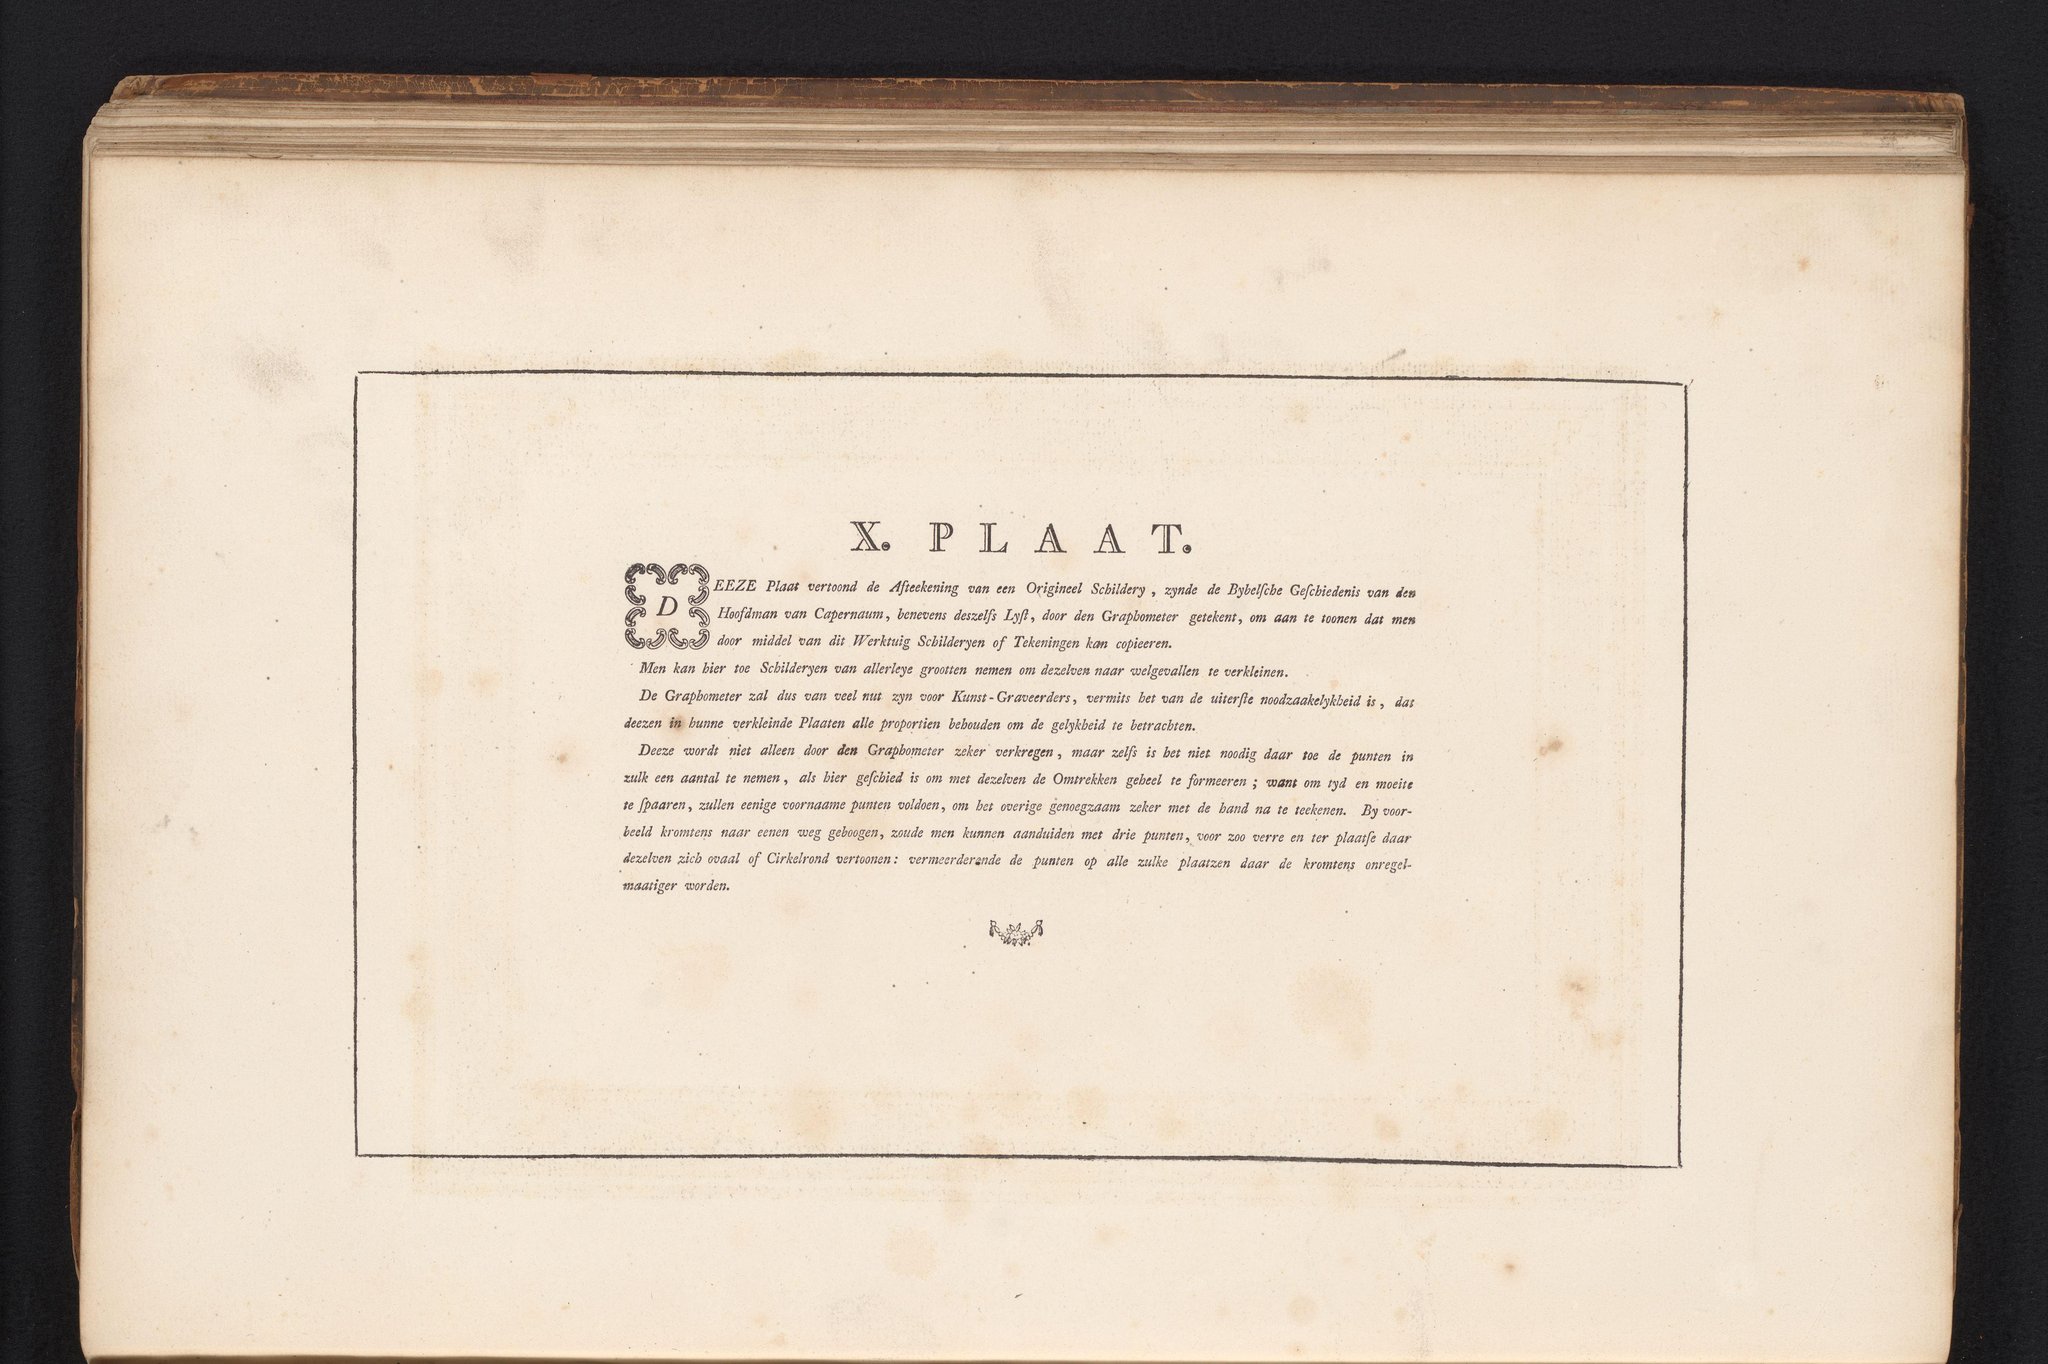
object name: album leaf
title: Toelichting bij een schilderij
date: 1777-1778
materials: paper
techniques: letterpress printing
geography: the hague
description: Tekstblad met een Nederlandstalige toelichting op een prent met een afbeelding van een lijst met een schilderij over de hoofdman van Kafarnaüm die Christus om hulp smeekt. Het schilderij is in omtrek getekend met behulp van een grafometer. Het tekstblad maakt deel uit van het boek: A.G. Eckhardt, Beschryving van een algemeenen graphometer, 1778.